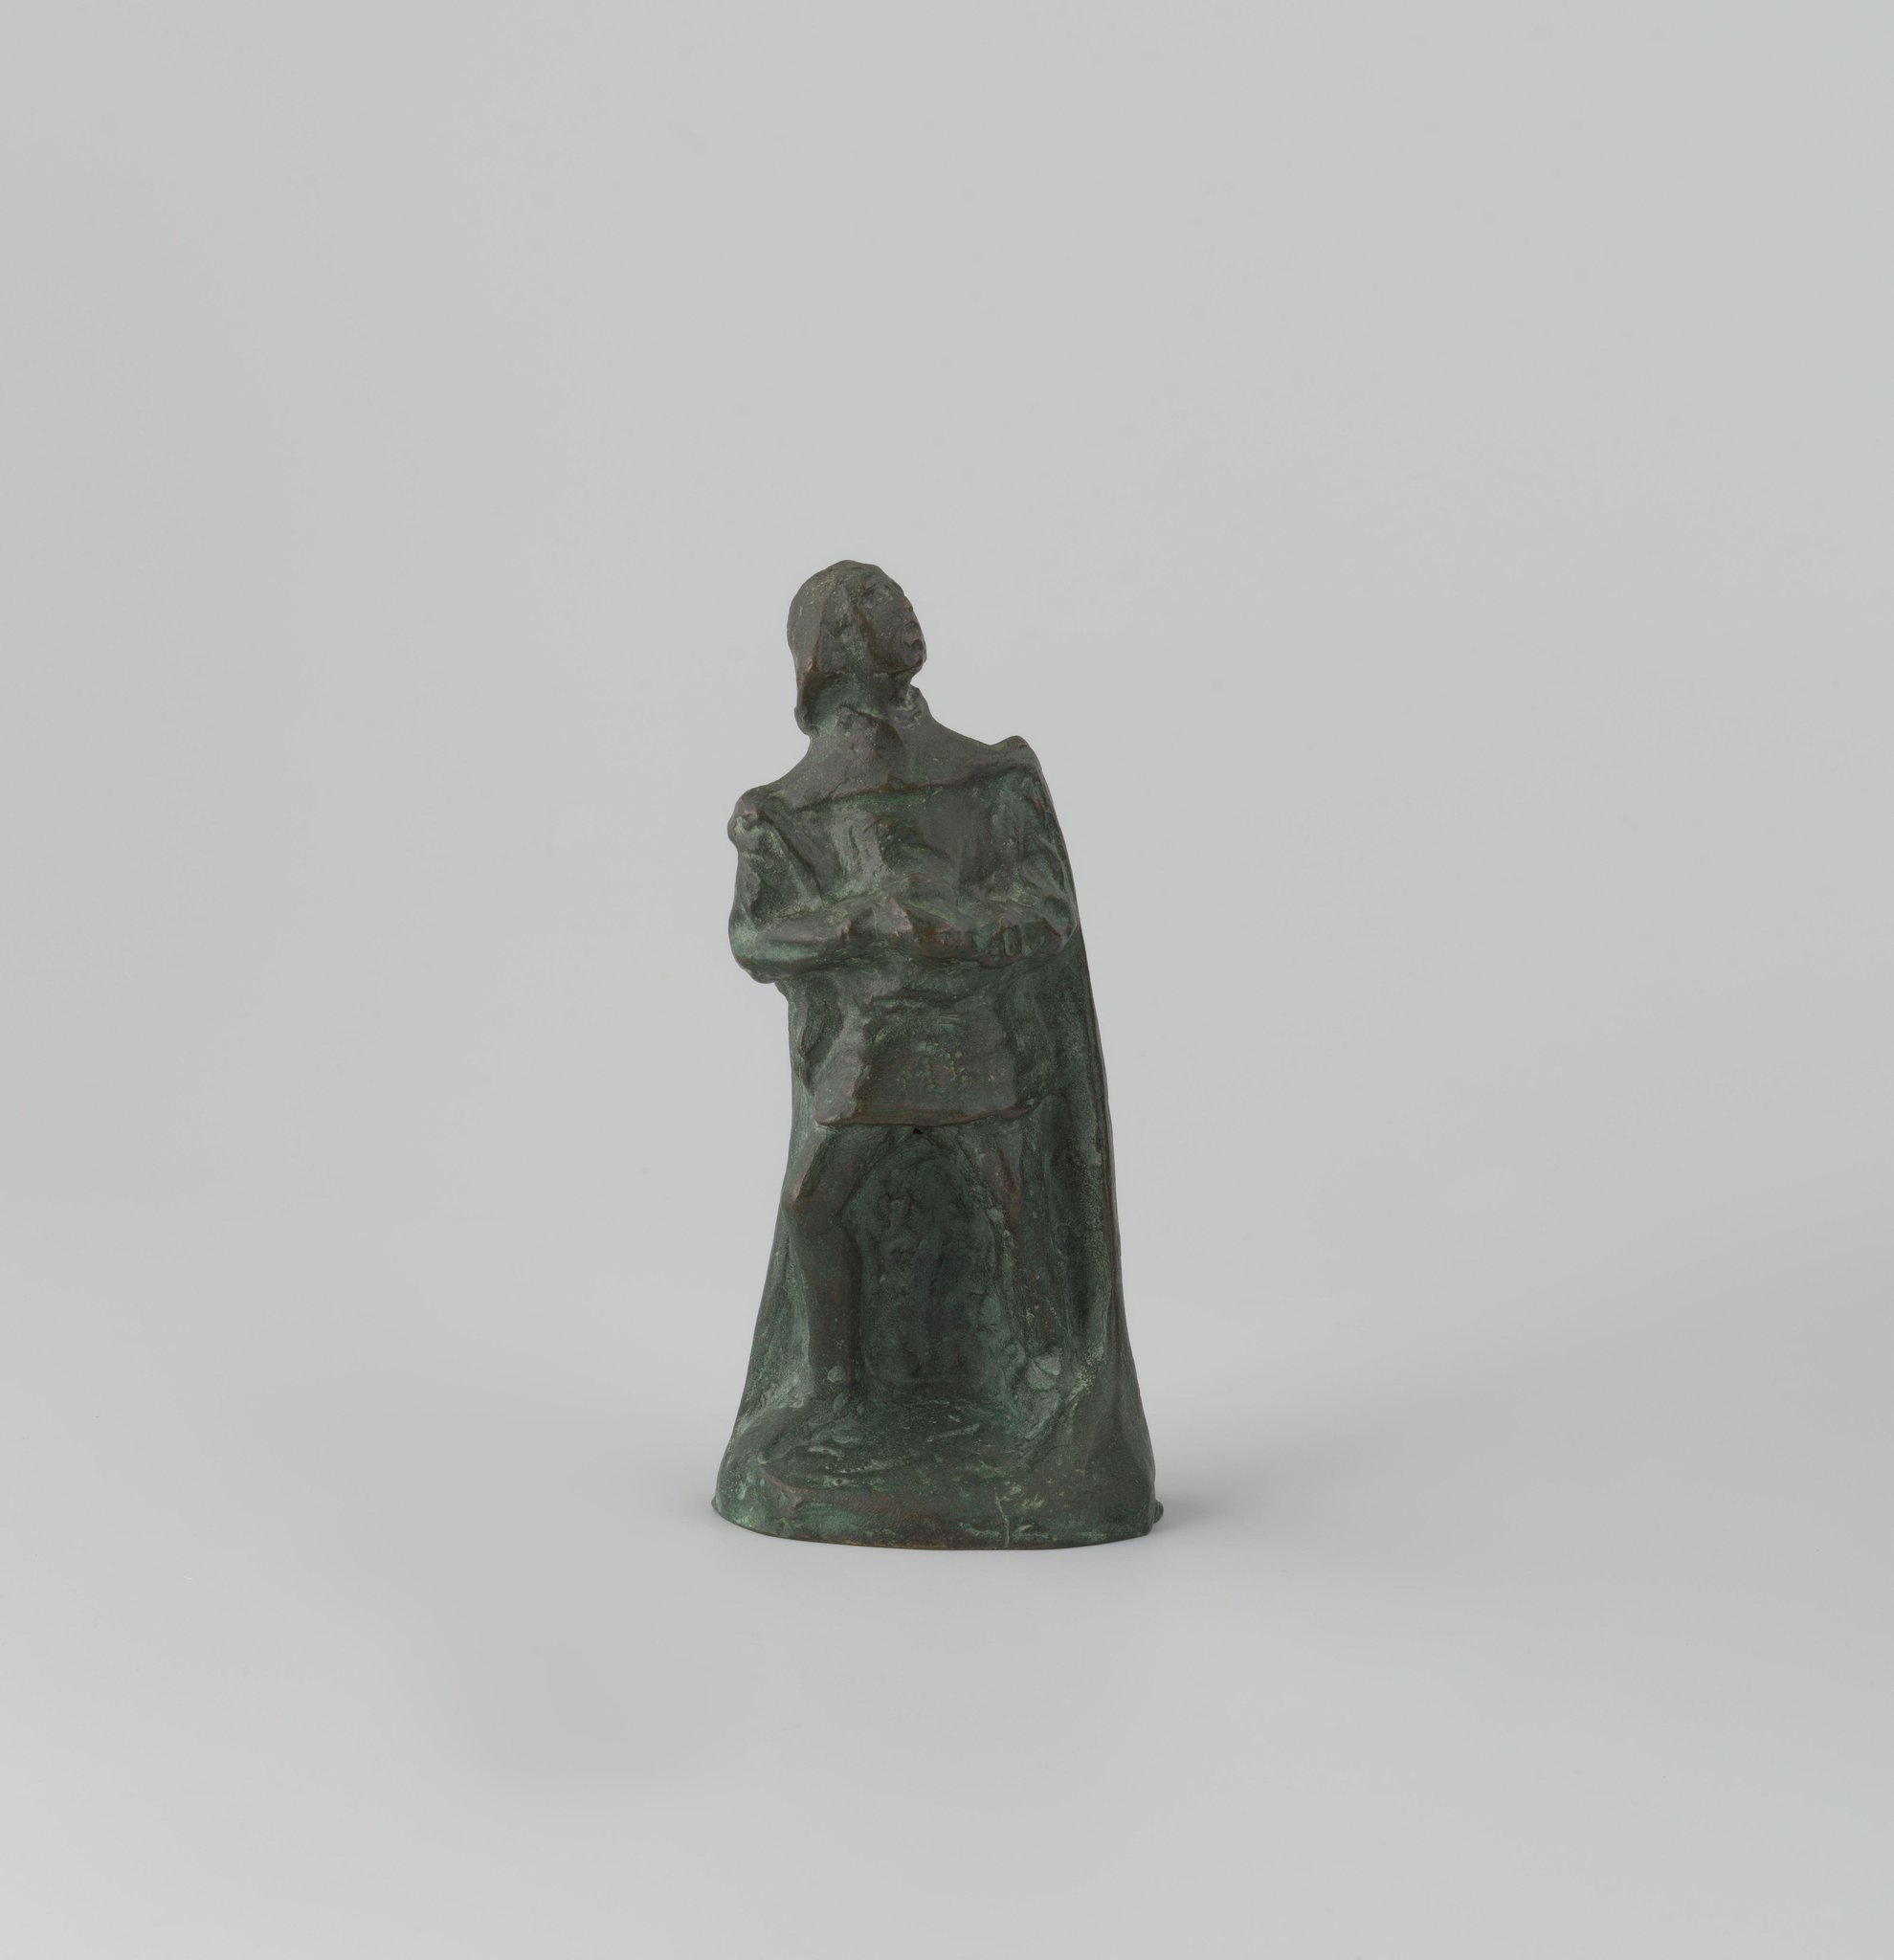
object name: chess piece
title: Pion 2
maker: saar de swart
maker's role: sculptor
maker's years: 1861-1951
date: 1923-1925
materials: bronze, oxide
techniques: casting, lost wax process, patinaed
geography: capri